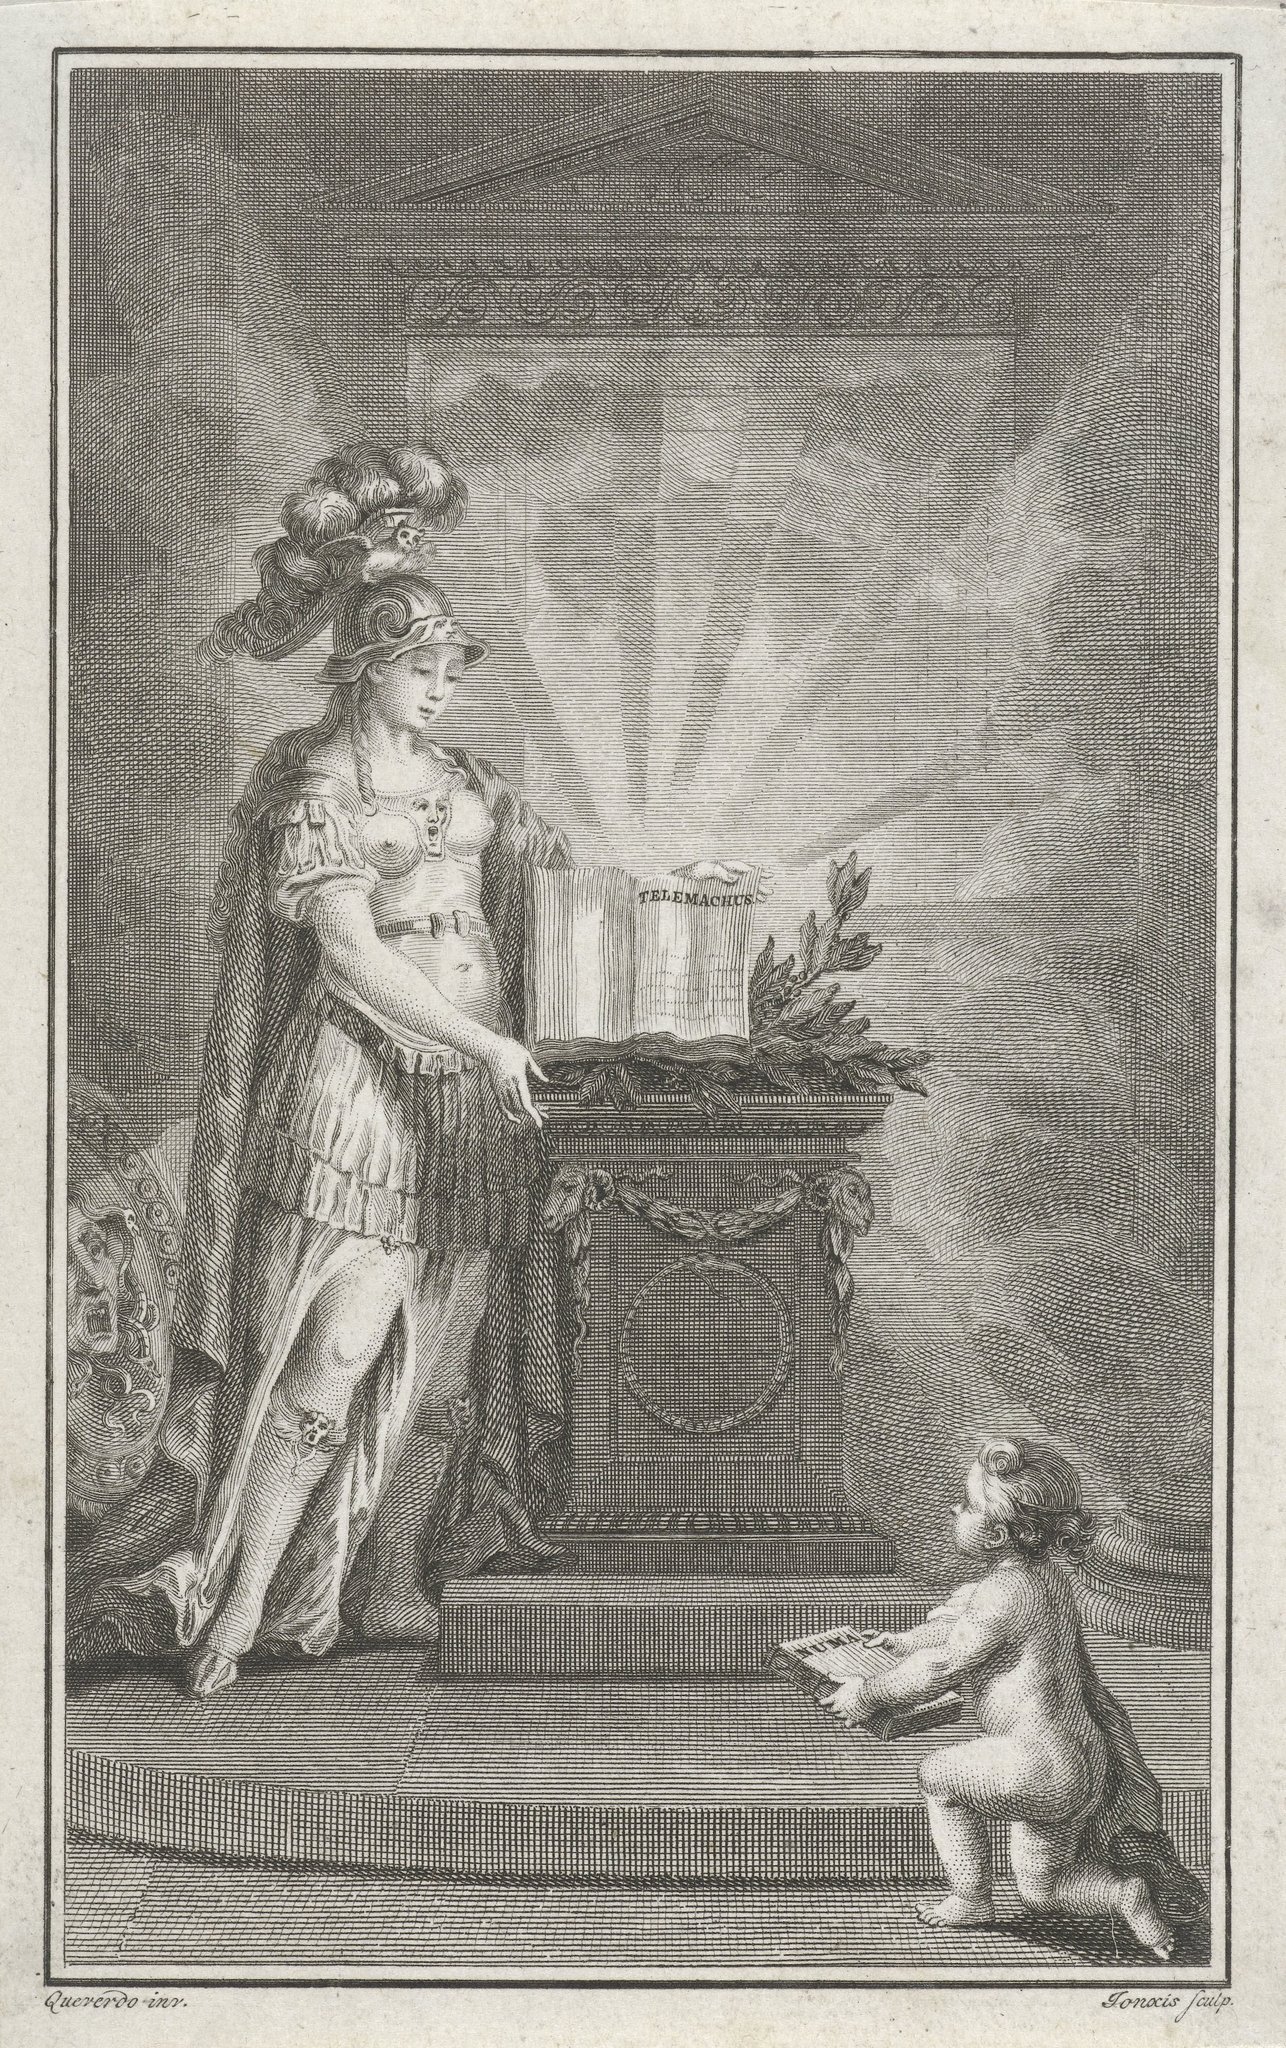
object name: print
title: Tempelinterieur met Minerva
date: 1772-1843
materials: paper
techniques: engraving, etching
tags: (story of) minerva (pallas, athena), temple, shrine ~ non-christian religions, (story of) telemachus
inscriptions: collector's mark: Lugt 2228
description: Tempelinterieur met Minerva bij een altaar. Met haar linkerhand houdt ze het boek over Telemachus, op het altaar, vast. Op de voorgrond een geknielde putto met een boek in de hand.